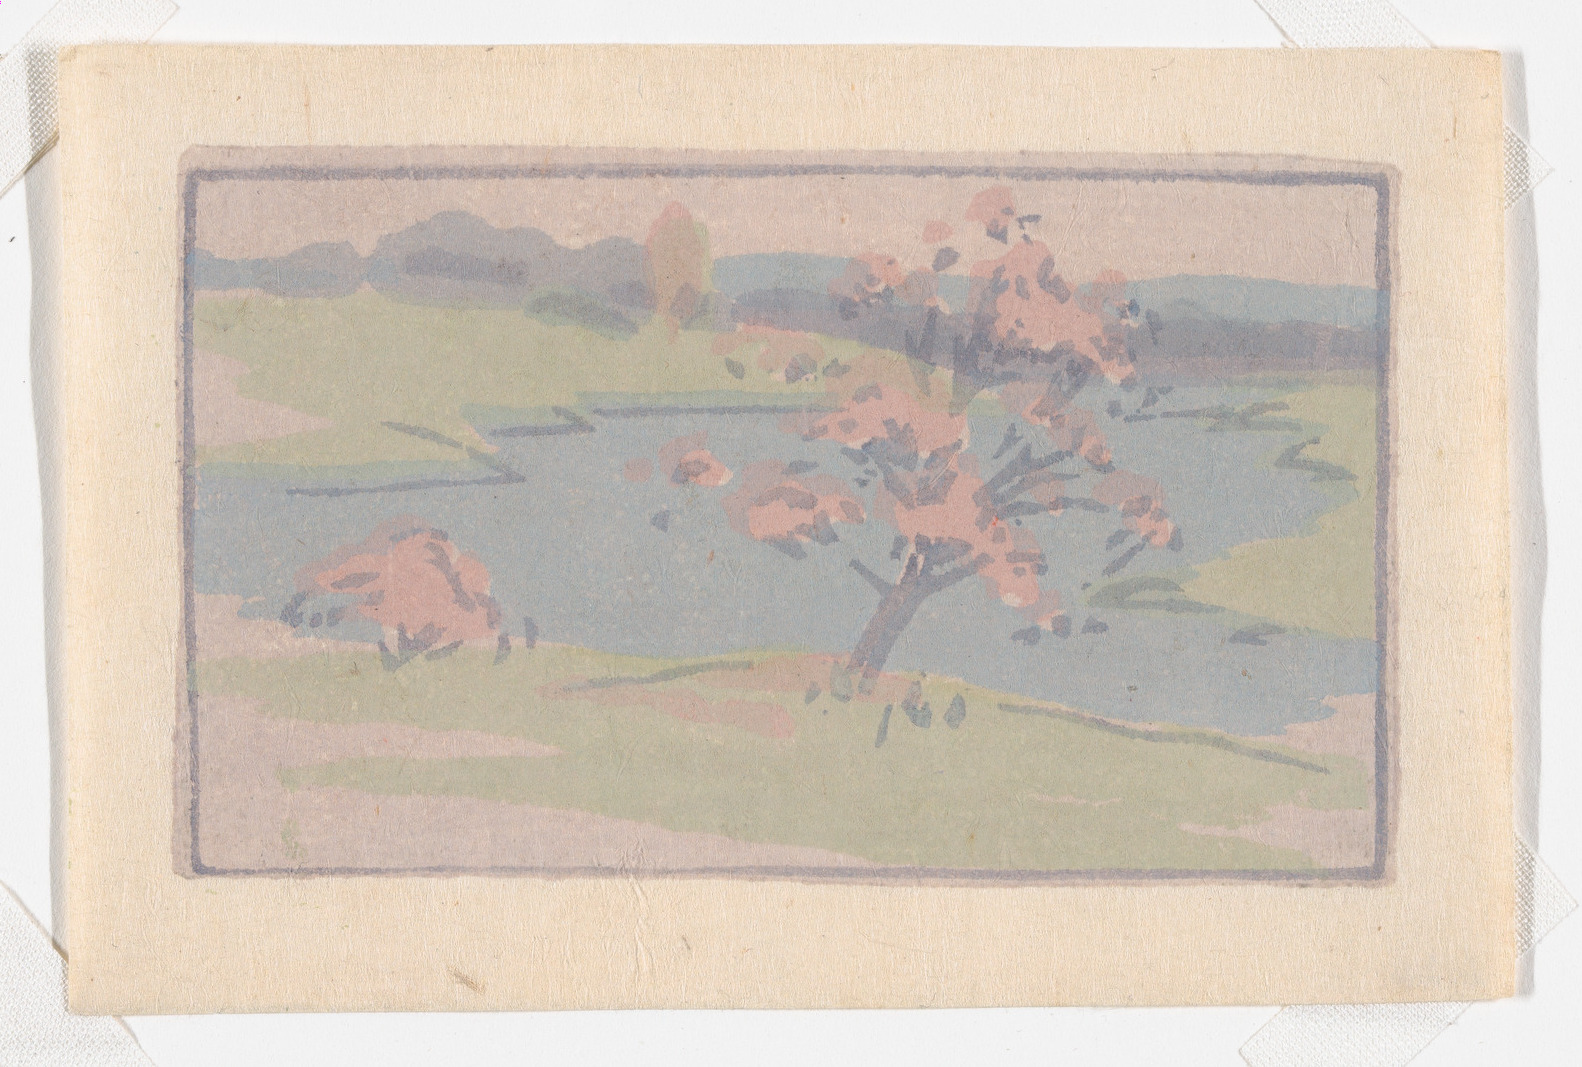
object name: woodcut, print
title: Nabby's Point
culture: american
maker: arthur wesley dow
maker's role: artist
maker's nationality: american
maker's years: 1857-1922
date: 1913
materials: paper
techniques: woodcut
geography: united states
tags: landscapes